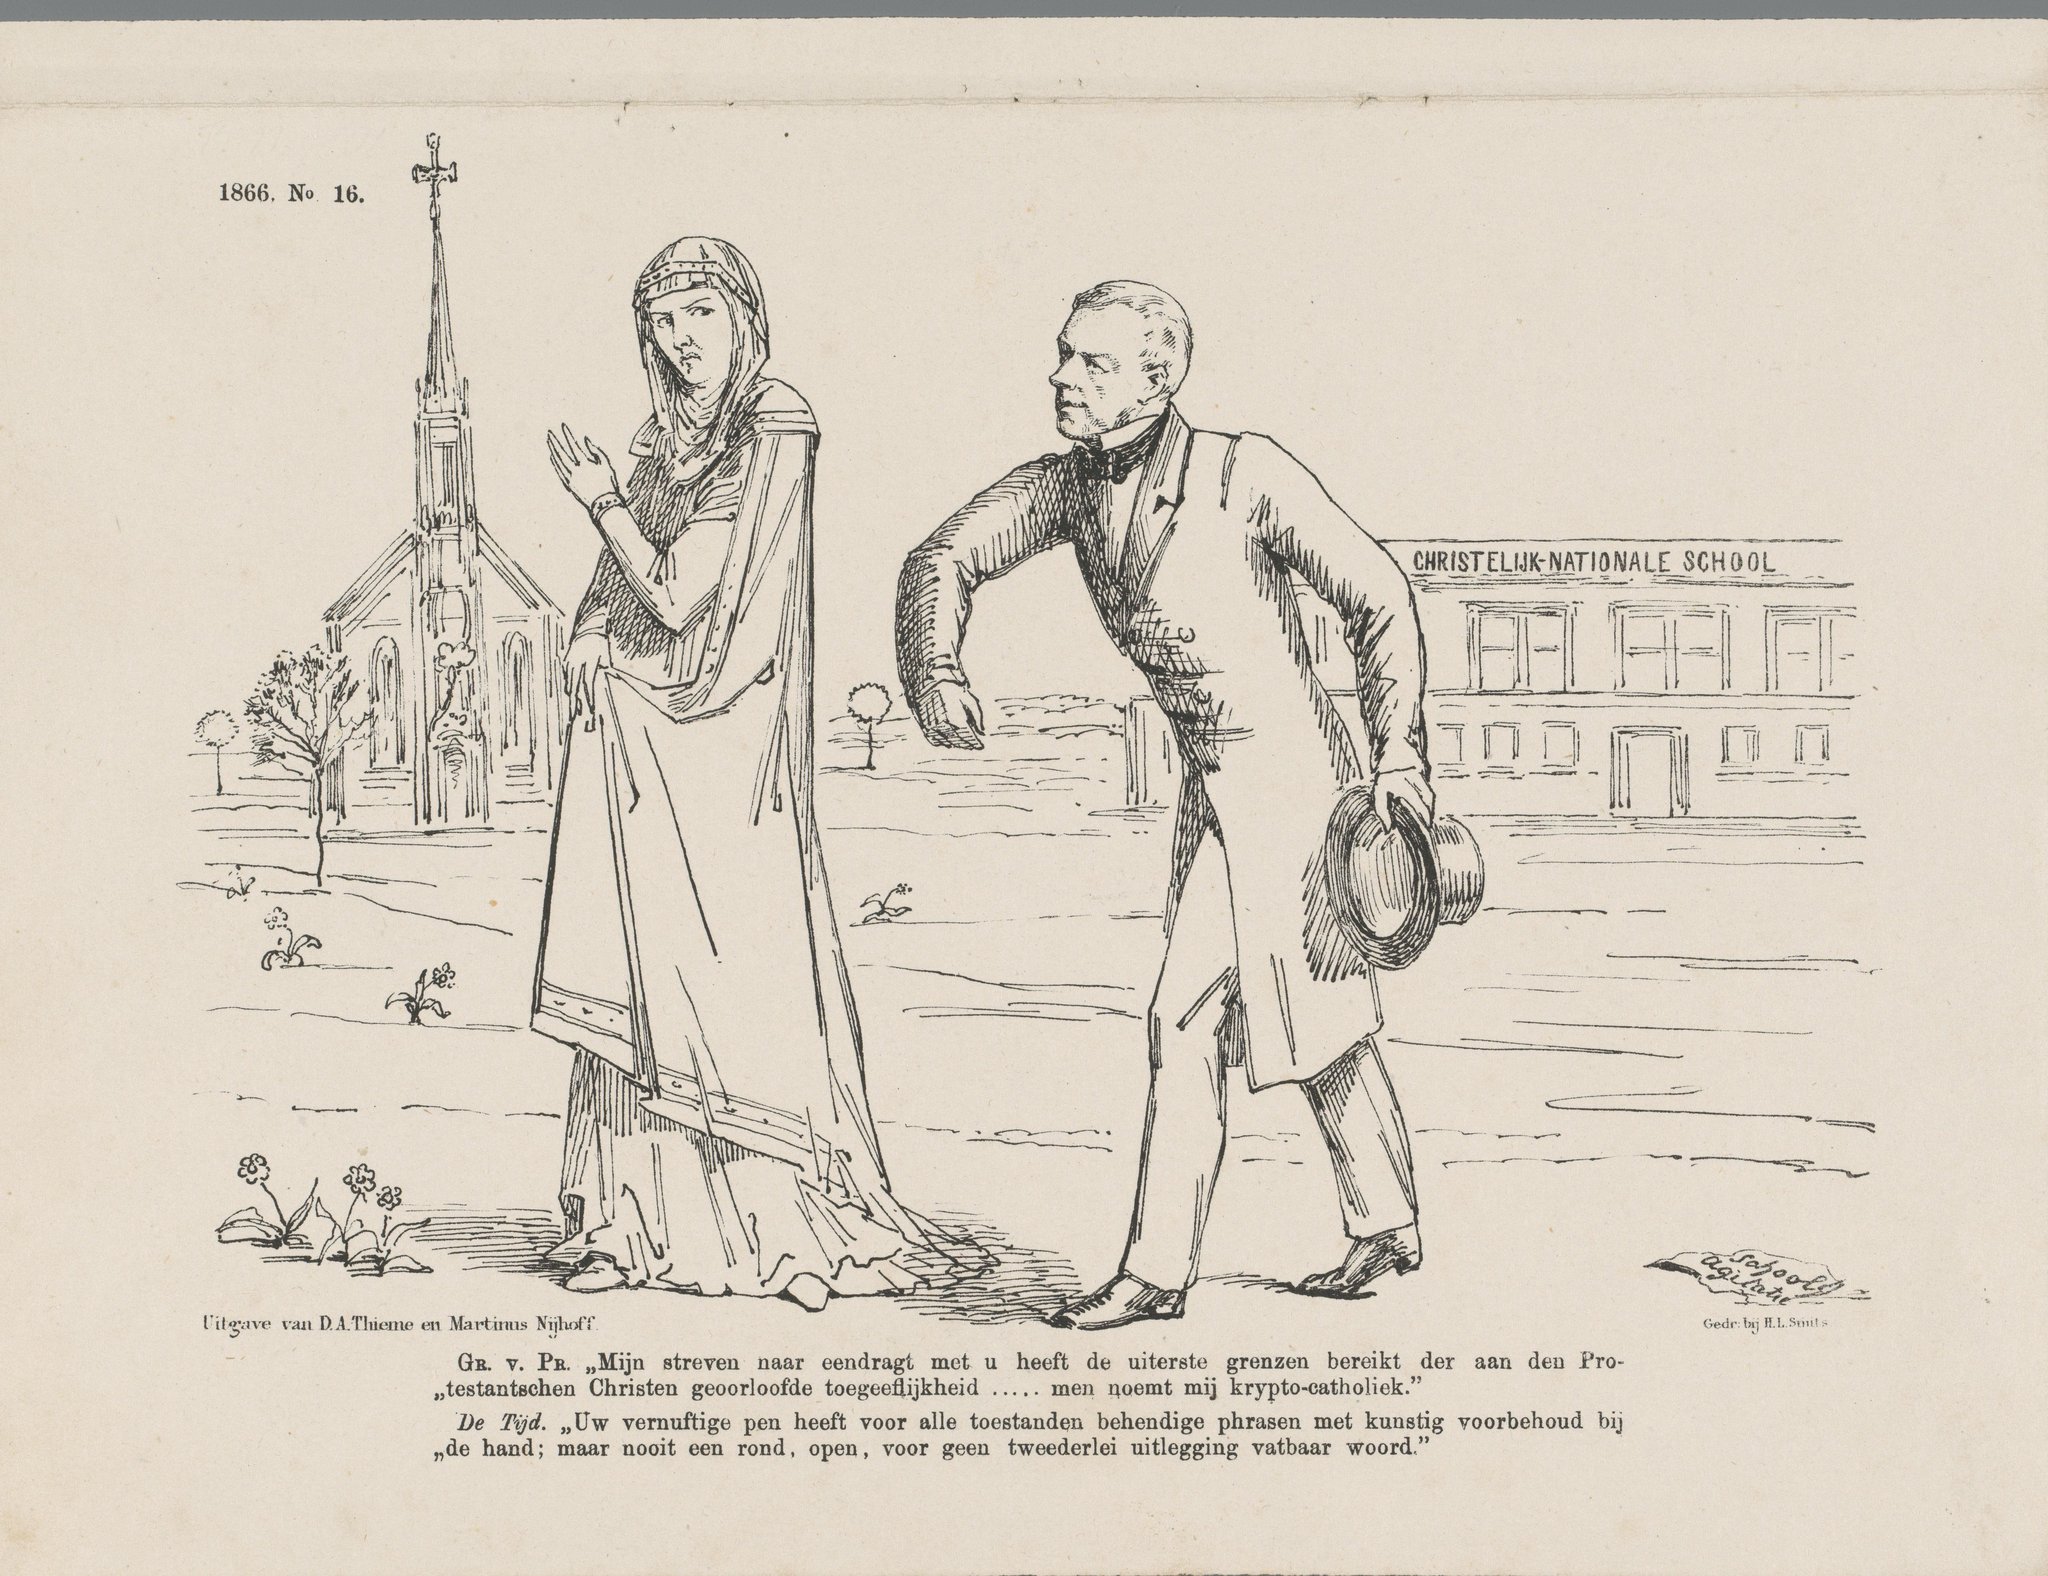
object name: cartoon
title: Spotprent op Groen van Prinsterer, 1866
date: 1866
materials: paper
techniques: lithograph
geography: netherlands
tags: guillaume groen van prinsterer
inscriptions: collector's mark: Lugt 2228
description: Spotprent op het voornemen van Groen van Prinsterer om samen met de katholieken het Openbaar Lager Onderwijs te bestrijden. Groen van Prinsterer maakt een jonge vrouw (de Tijd) tevergeefs het hof. Plaat verschenen bij het weekblad De Nederlandsche Spectator, nr. 16, 21 april 1866.